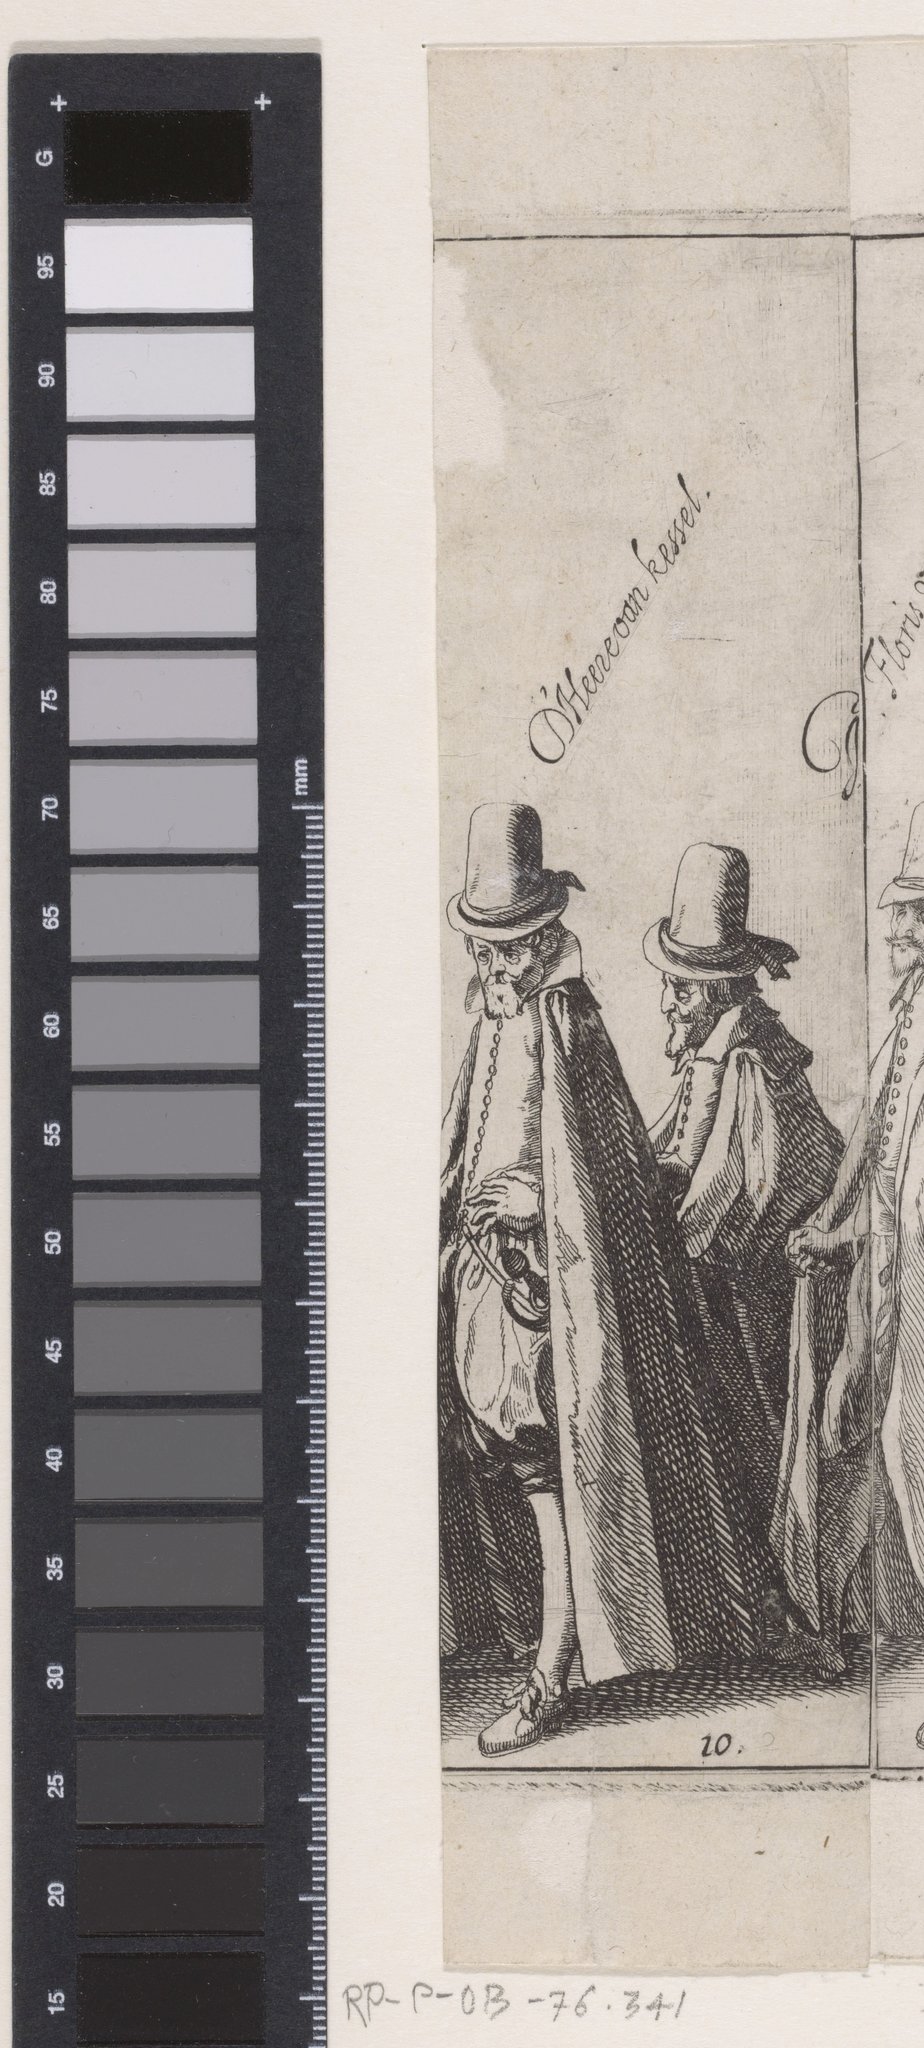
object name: print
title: Begrafenis van Walraven van Brederode, 1615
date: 1615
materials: paper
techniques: etching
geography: northern netherlands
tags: cortege, funeral procession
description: De begrafenisstoet (klein fragment van plaat 10 vastgeplakt aan plaat 11). Onderdeel van de serie prenten van de begrafenisoptocht van Walraven van Brederode, heer van Vianen, op 29 januari 1615 te Vianen.